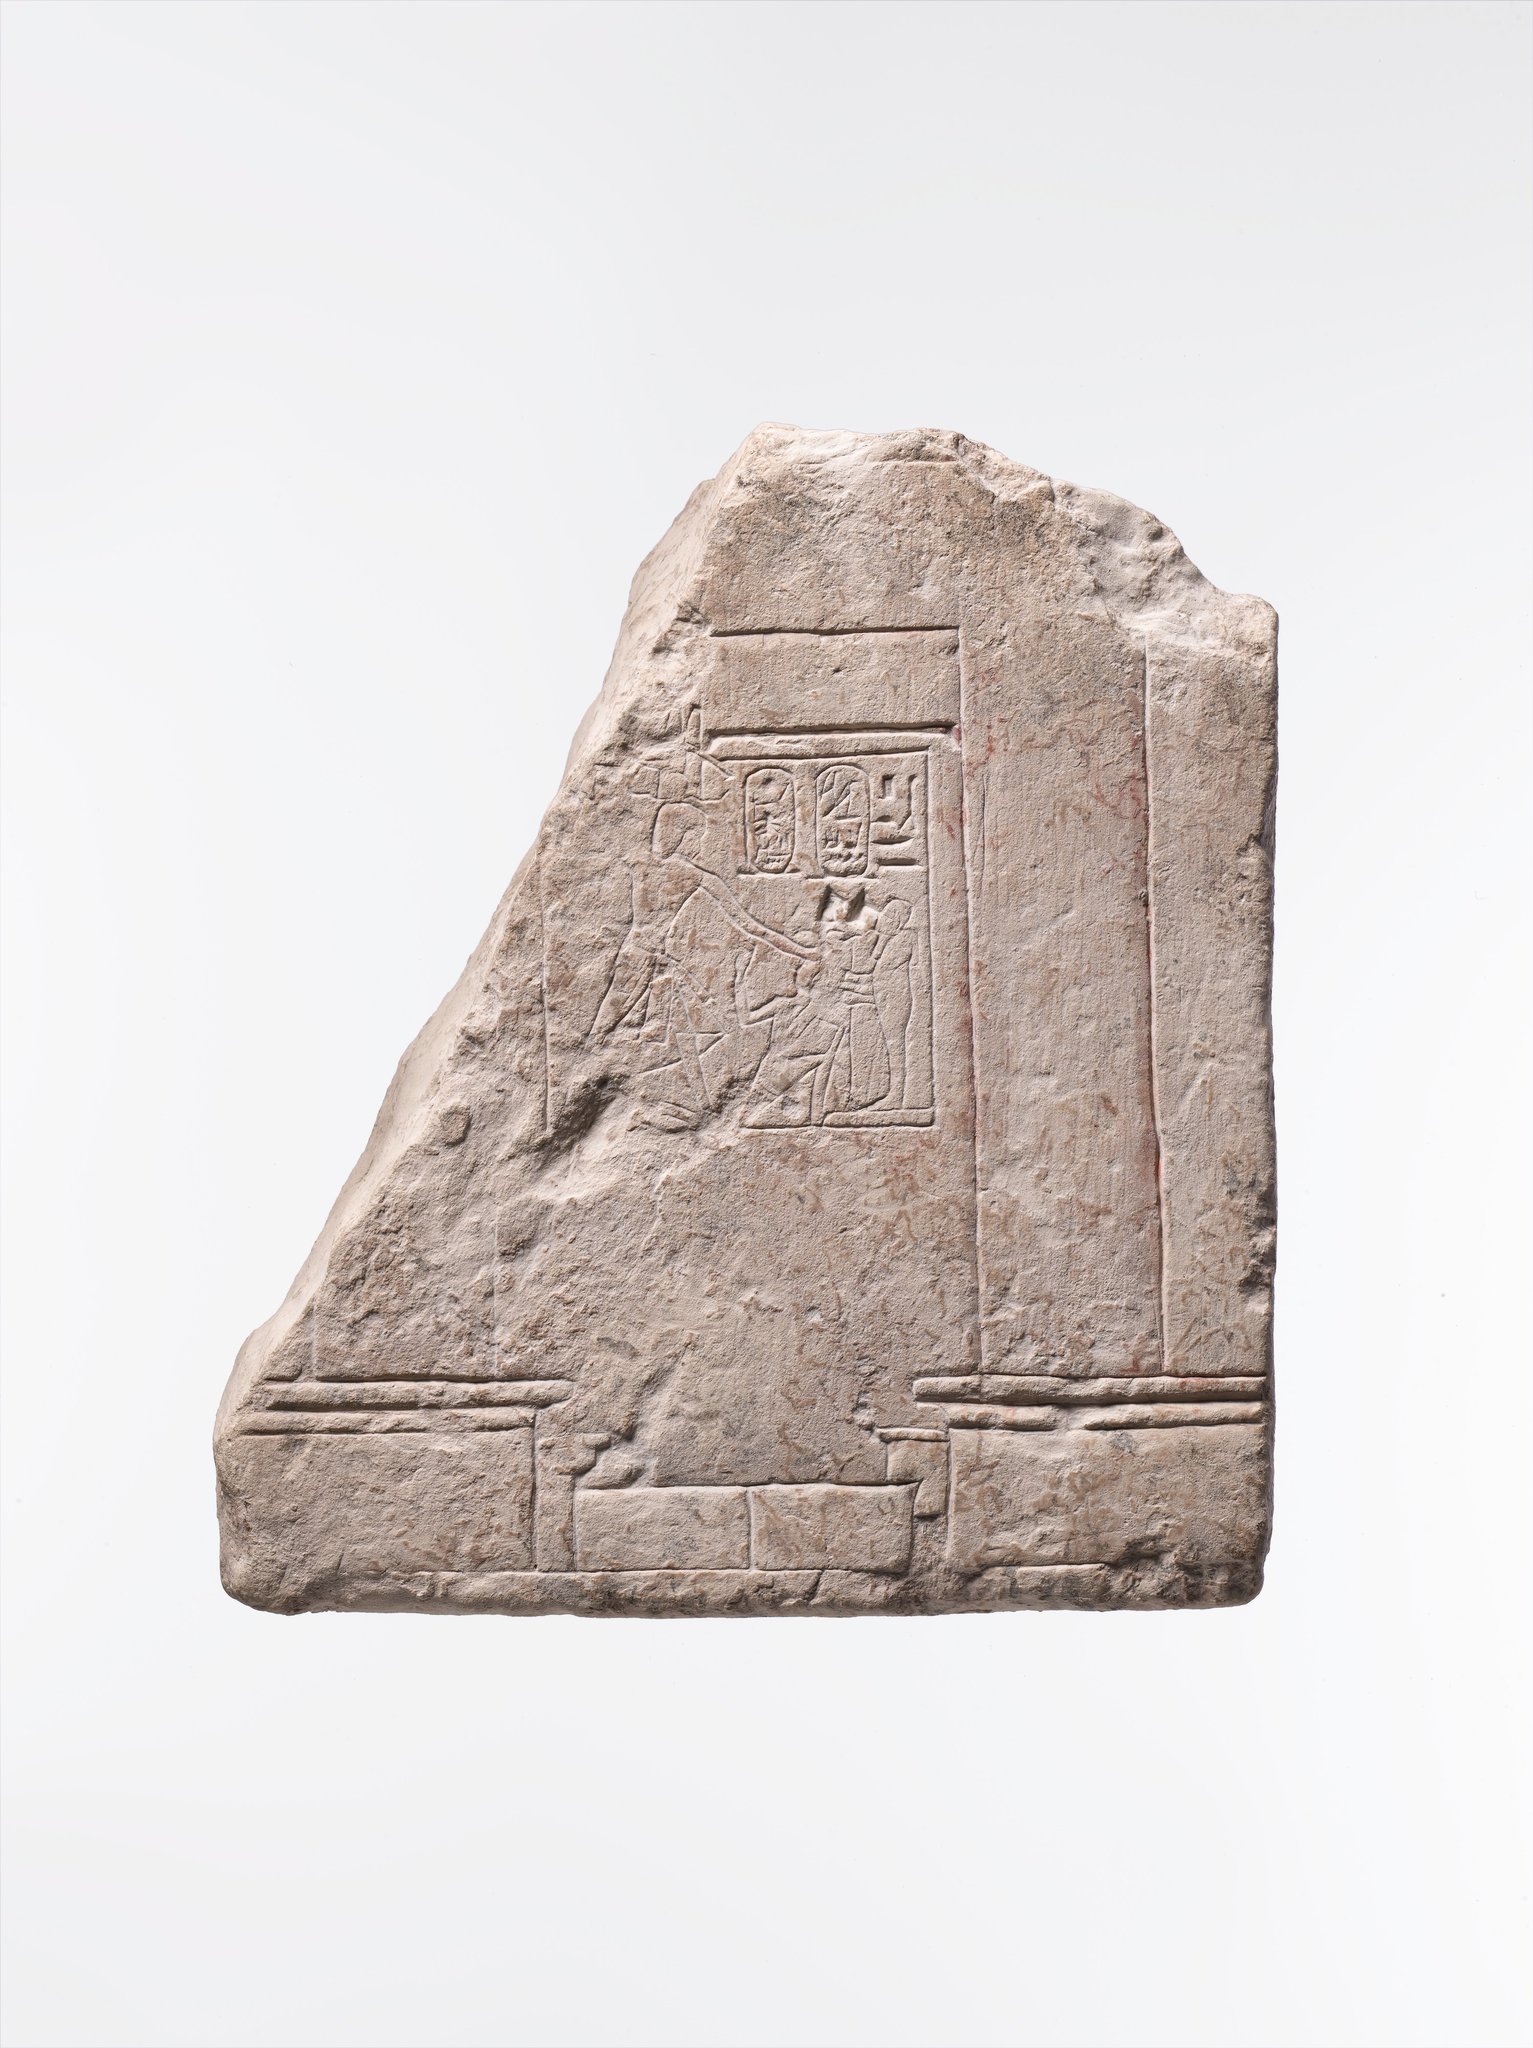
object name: relief, haremhab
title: Relief showing part of a temple of Ptah with Haremhab smiting an enemy in front of the god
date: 1353-1295 BCE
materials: limestone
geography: egypt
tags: hieroglyphs